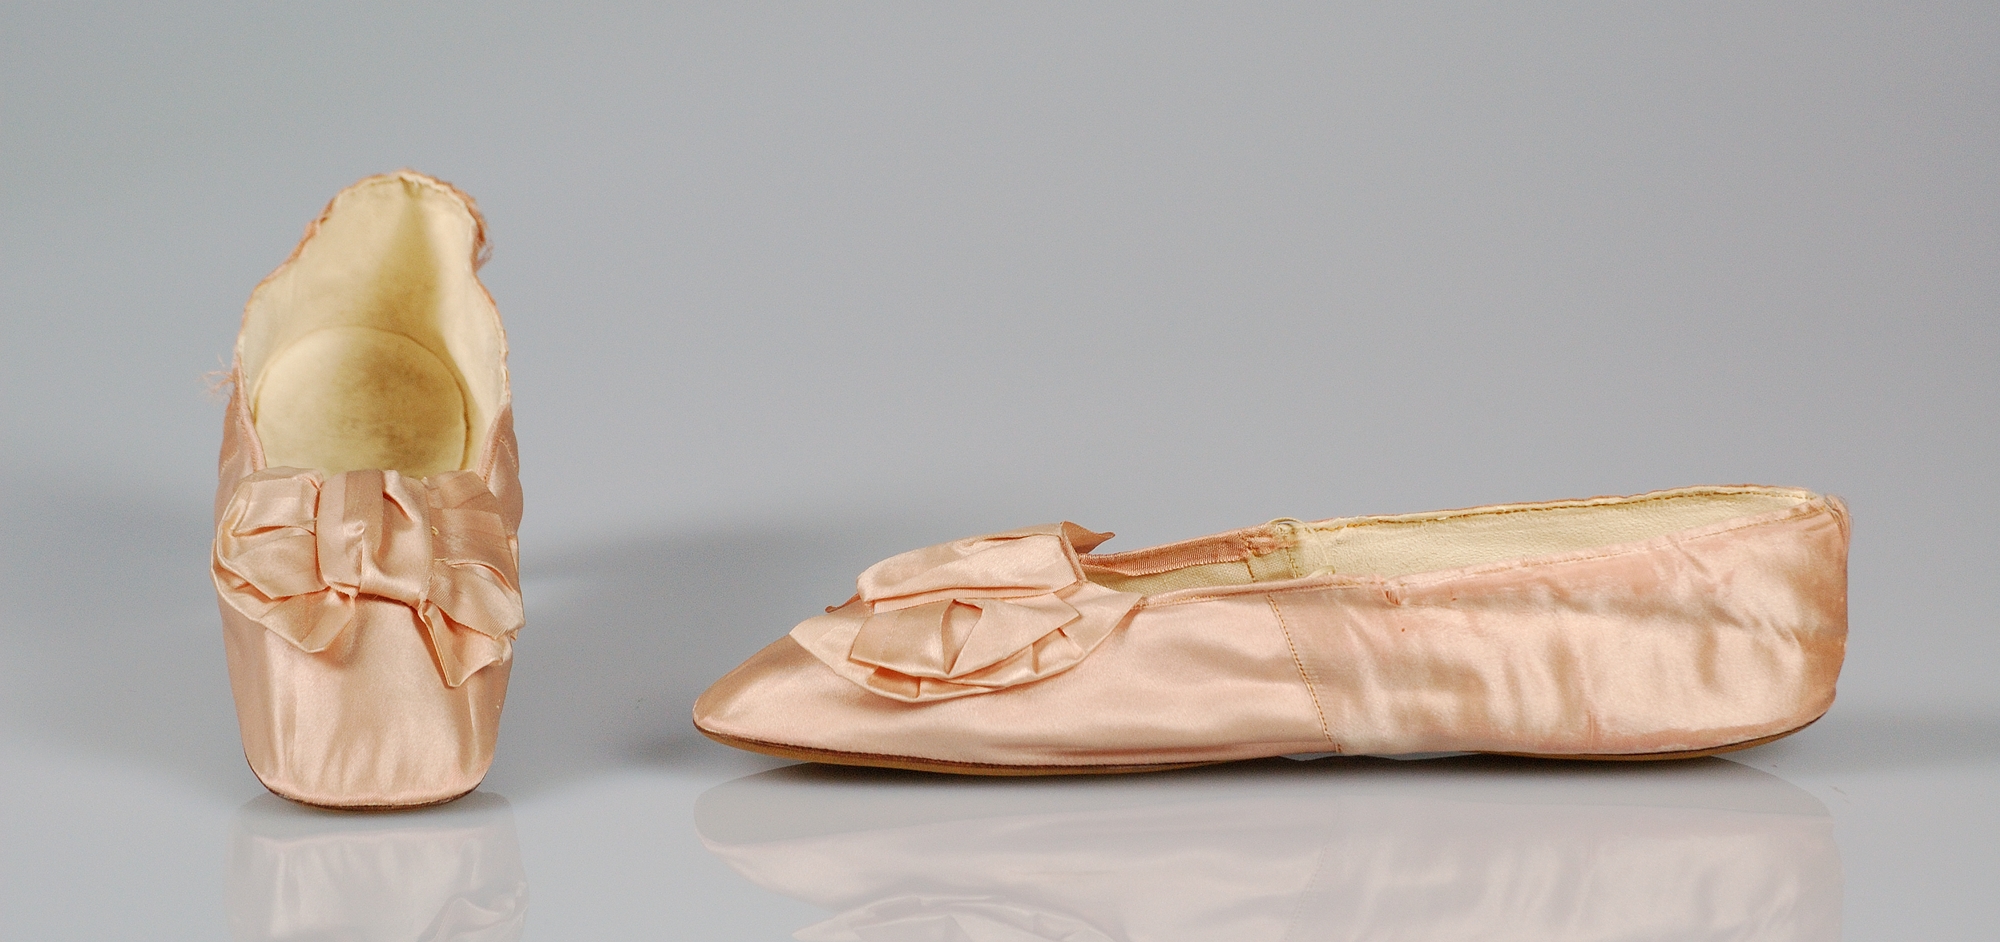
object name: evening slipper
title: Evening slippers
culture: american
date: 1855-1869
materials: silk